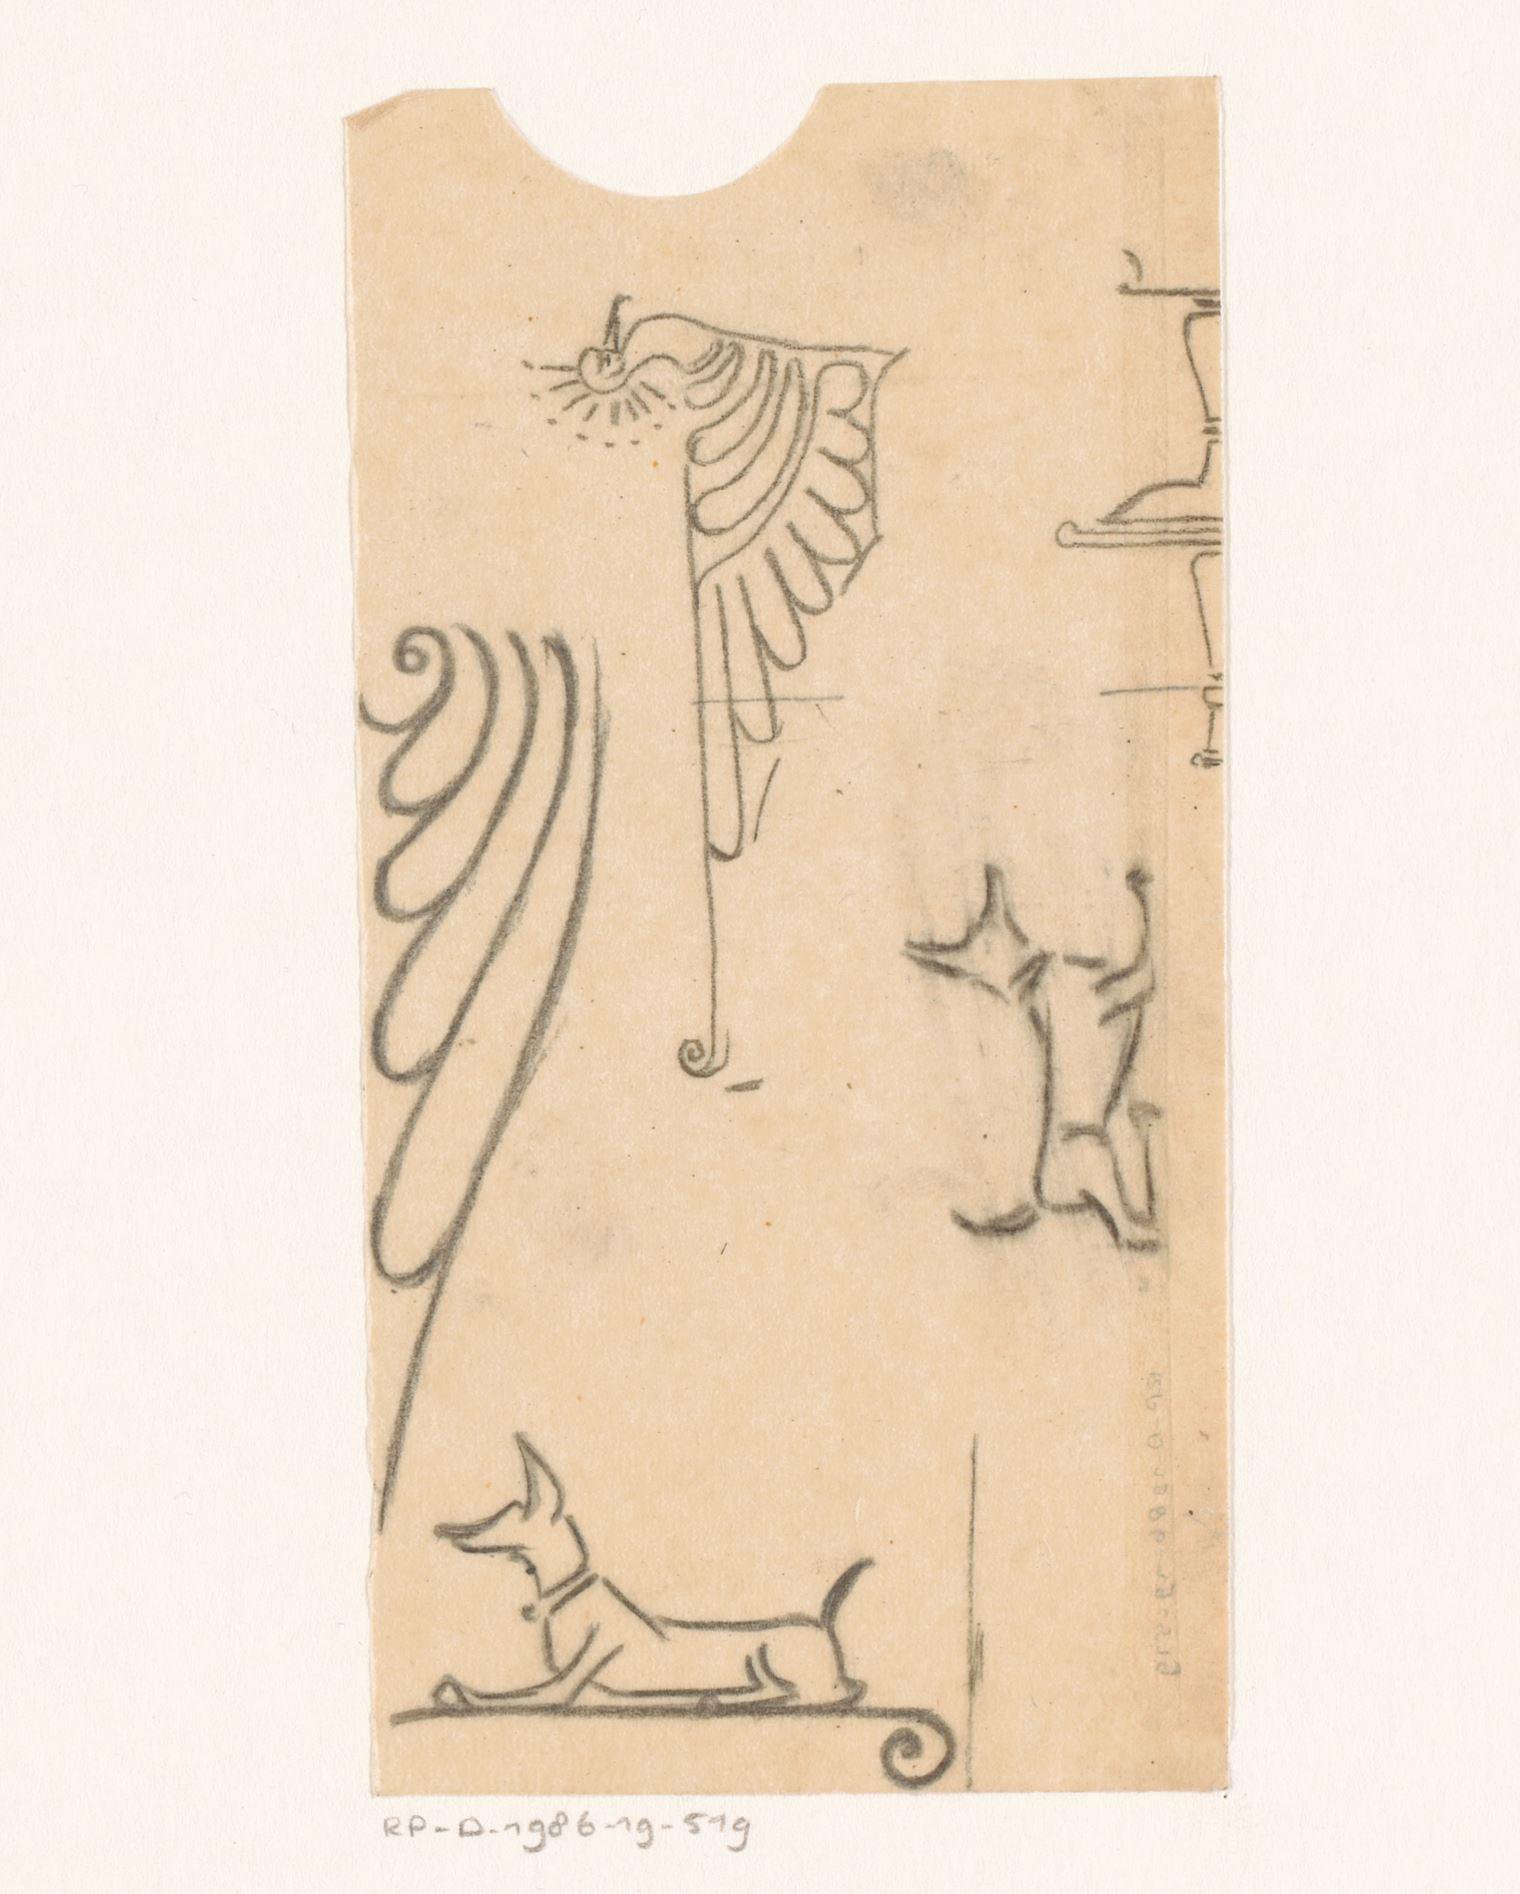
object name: drawing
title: Studieblad met honden en vleugels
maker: reinier willem petrus de vries (1874-1953)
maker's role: draughtsman, print maker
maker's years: 1874-1953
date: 1884-1952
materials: pencil, paper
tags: dog